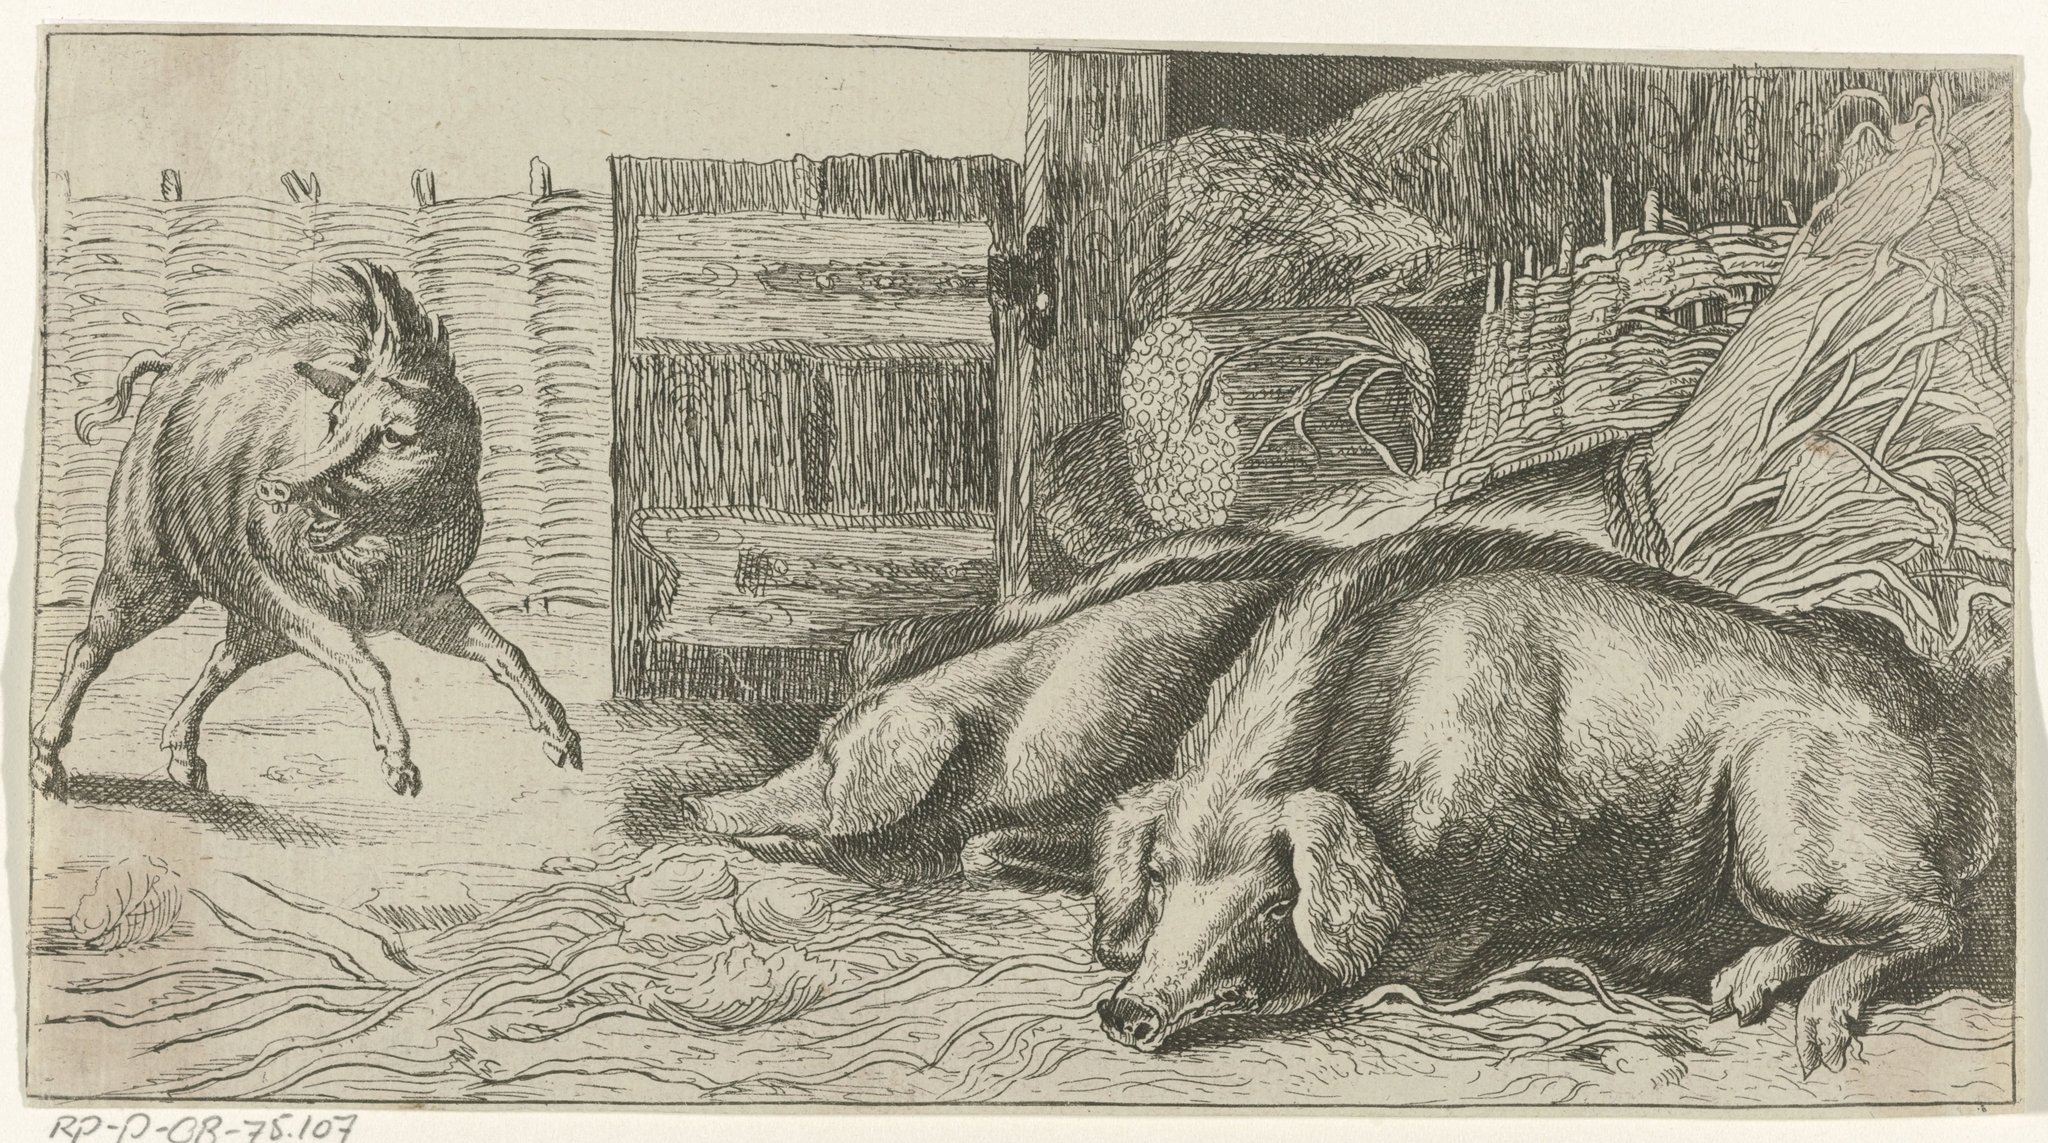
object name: print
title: Varkens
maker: Anonymous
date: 1610-1703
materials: paper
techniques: engraving, etching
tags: pig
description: Twee liggende varkens in een stal. Links een rennend varken.